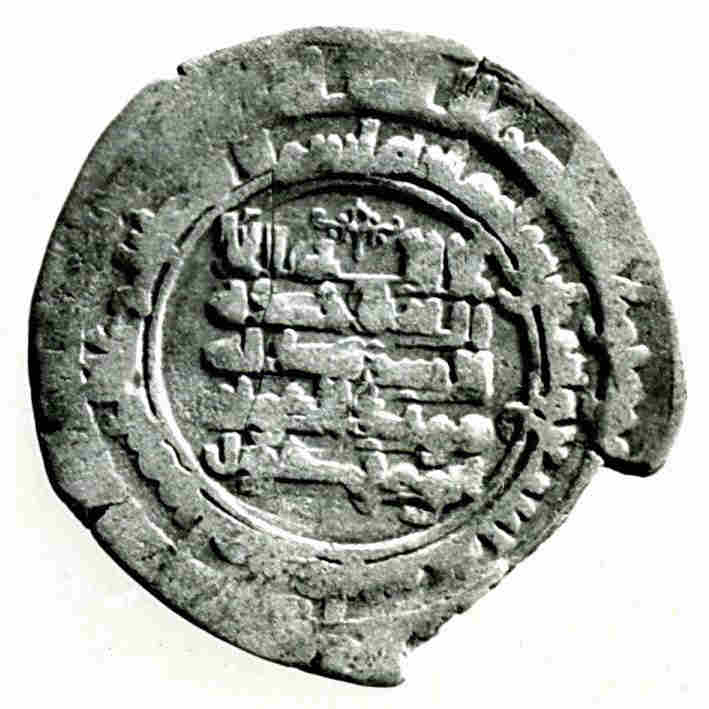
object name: coin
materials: silver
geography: amul